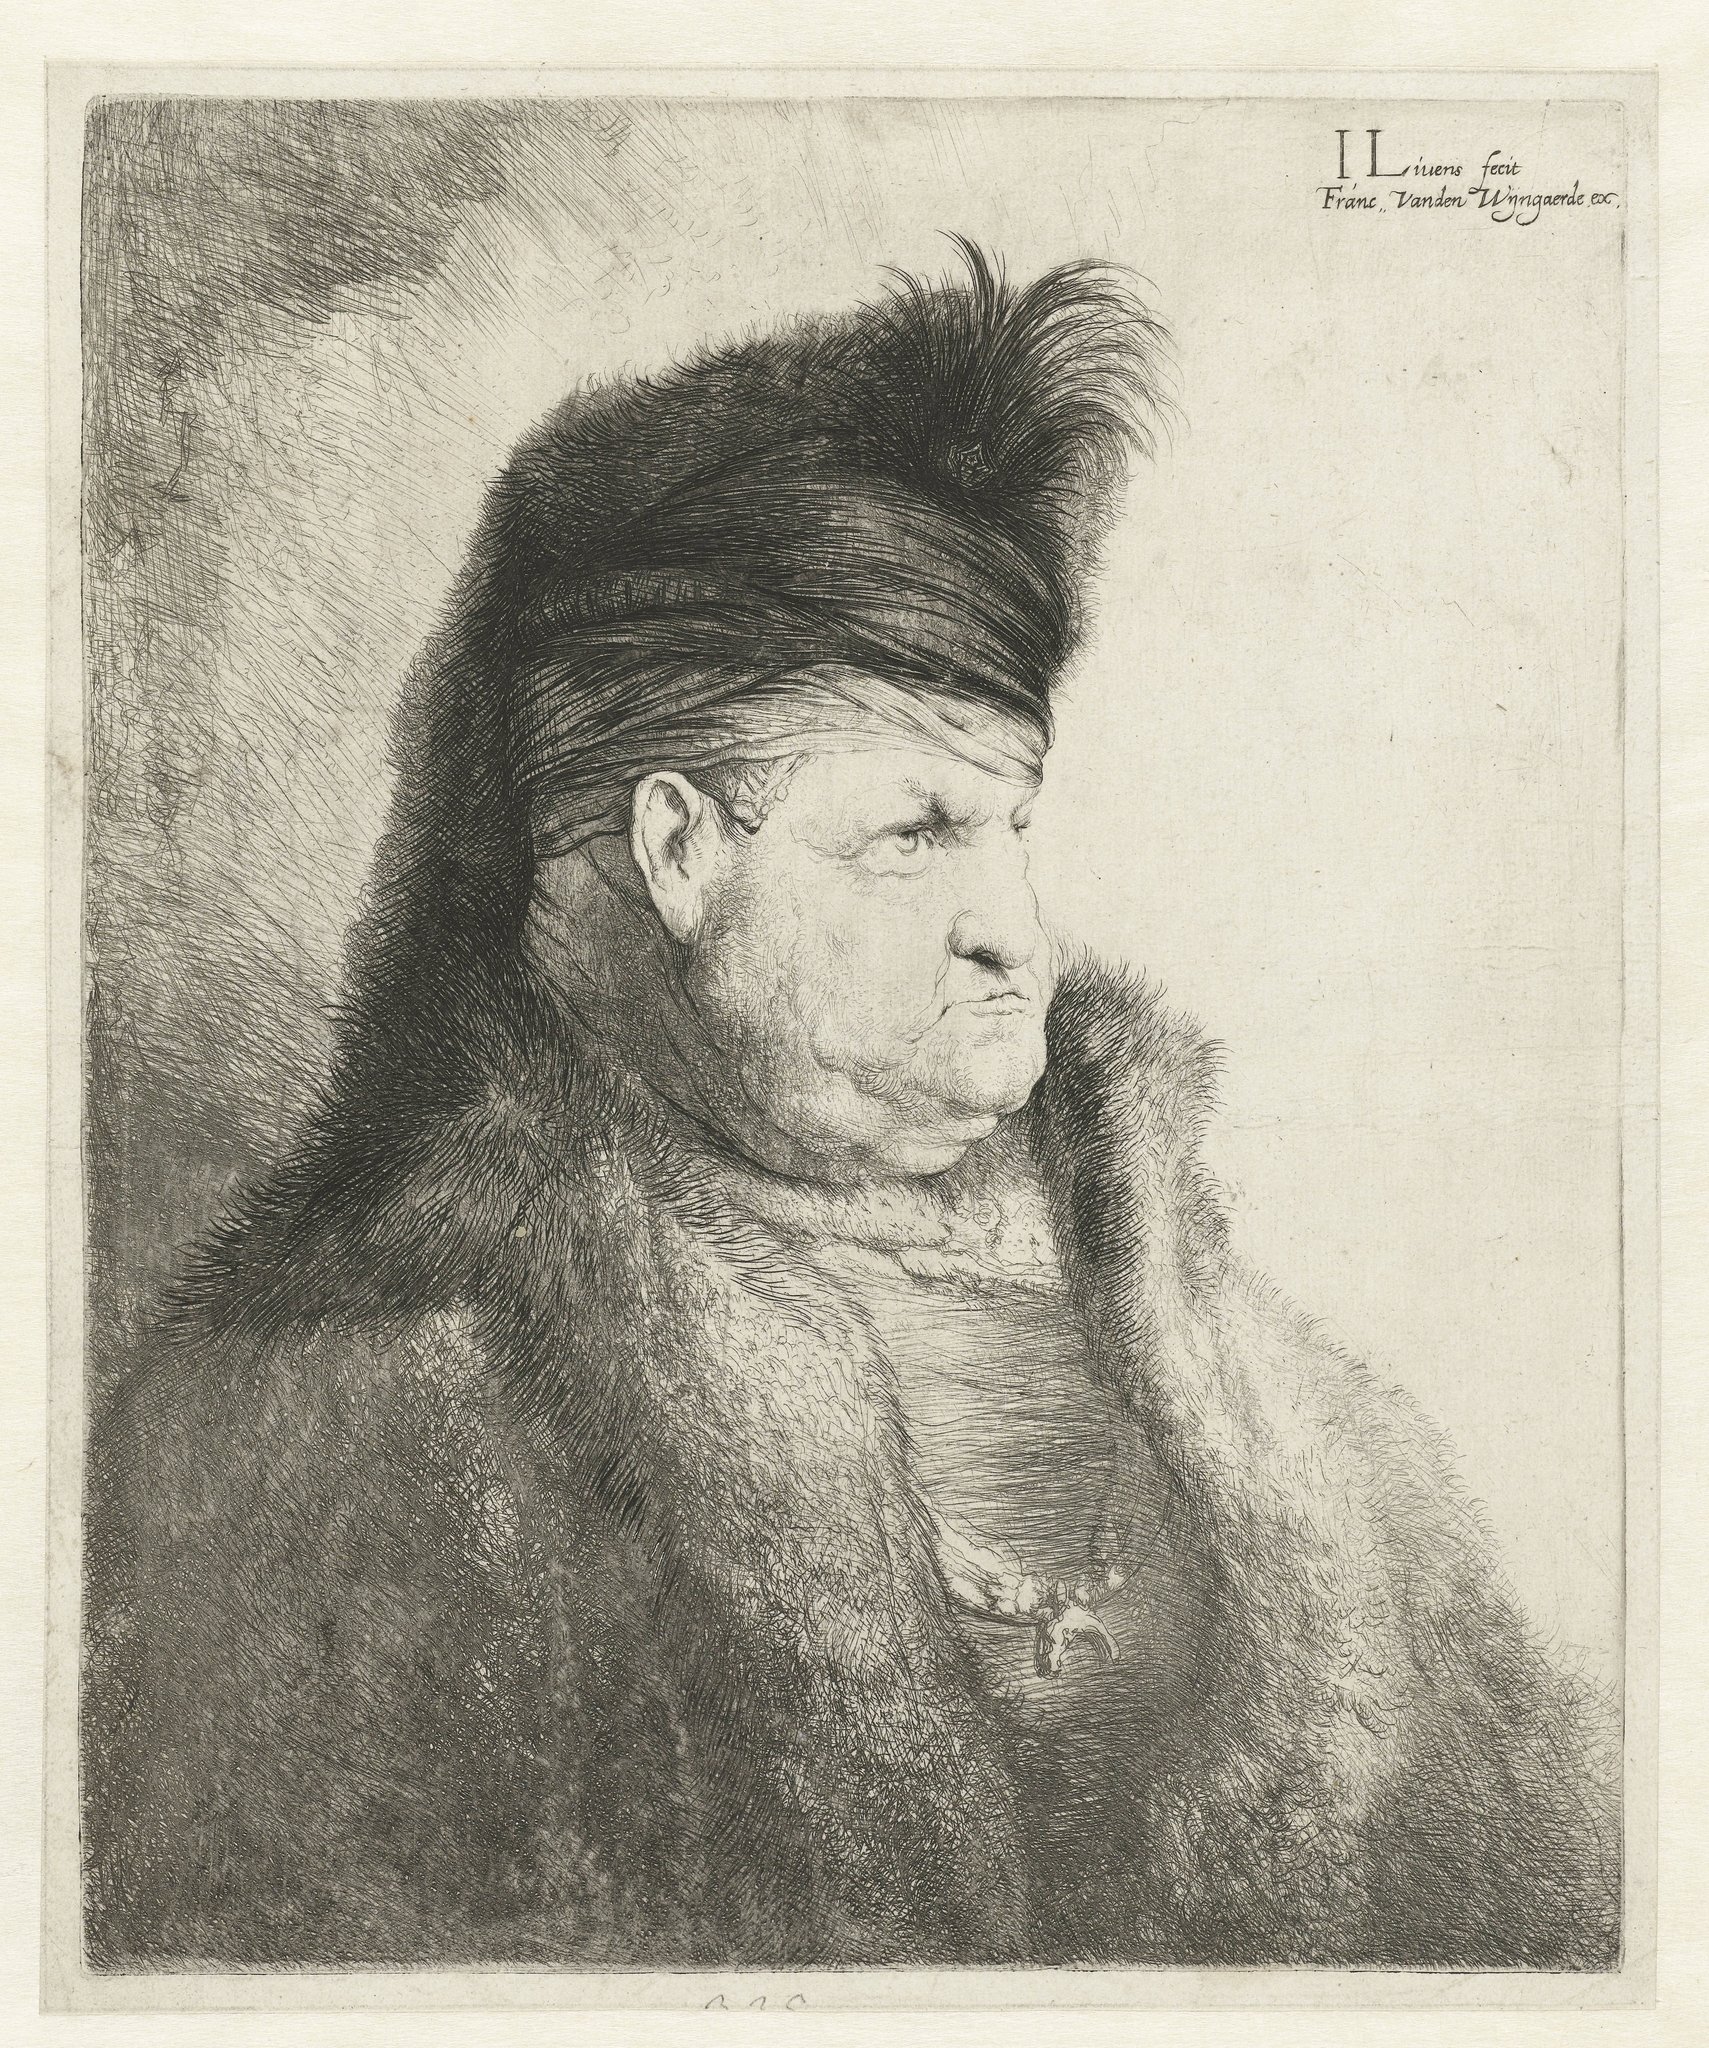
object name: print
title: Borstbeeld van een oosterling met tulband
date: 1625-1632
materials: paper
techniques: engraving, etching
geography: antwerp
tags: head-gear: turban, human races; peoples; nationalities (+ costume), fashion, clothing (+ fur used for clothes), male sex; man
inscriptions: collector's mark: Lugt 240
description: Bij Hollstein wordt een staat niet vermeld, er zijn vier staten van deze prent bekend (Schatborn 1988)